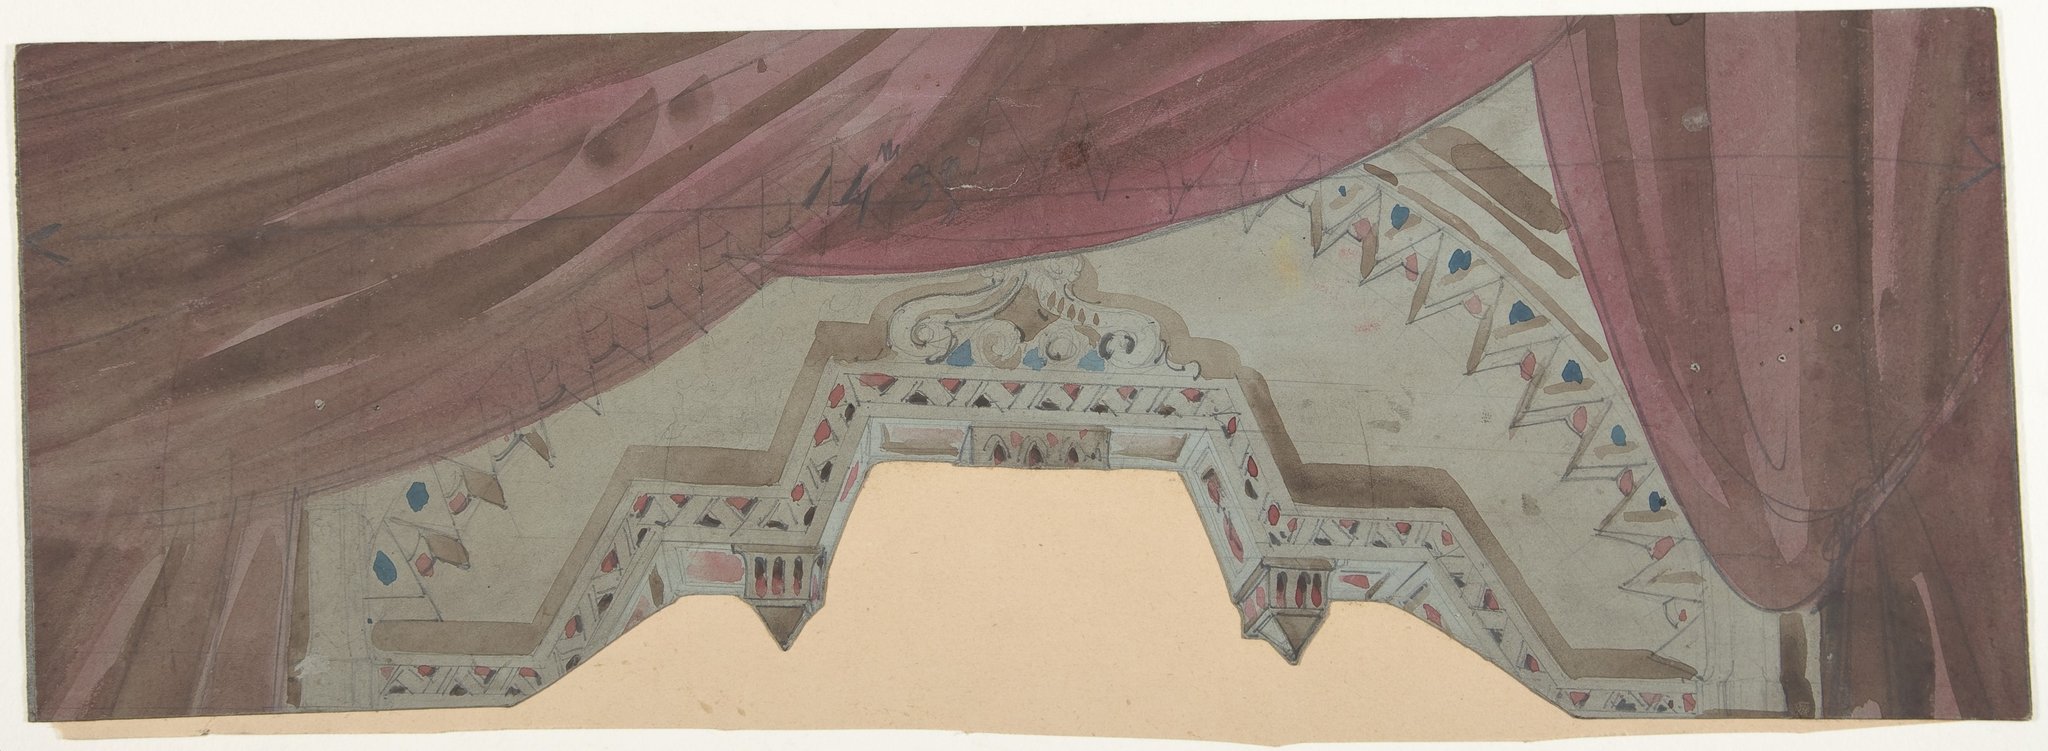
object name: drawing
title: Design for a Stage Set at the Opéra, Paris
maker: eugène cicéri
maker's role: artist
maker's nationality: french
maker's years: 1813-1890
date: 1830-1890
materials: graphite, watercolor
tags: theatre,curtains,stage design